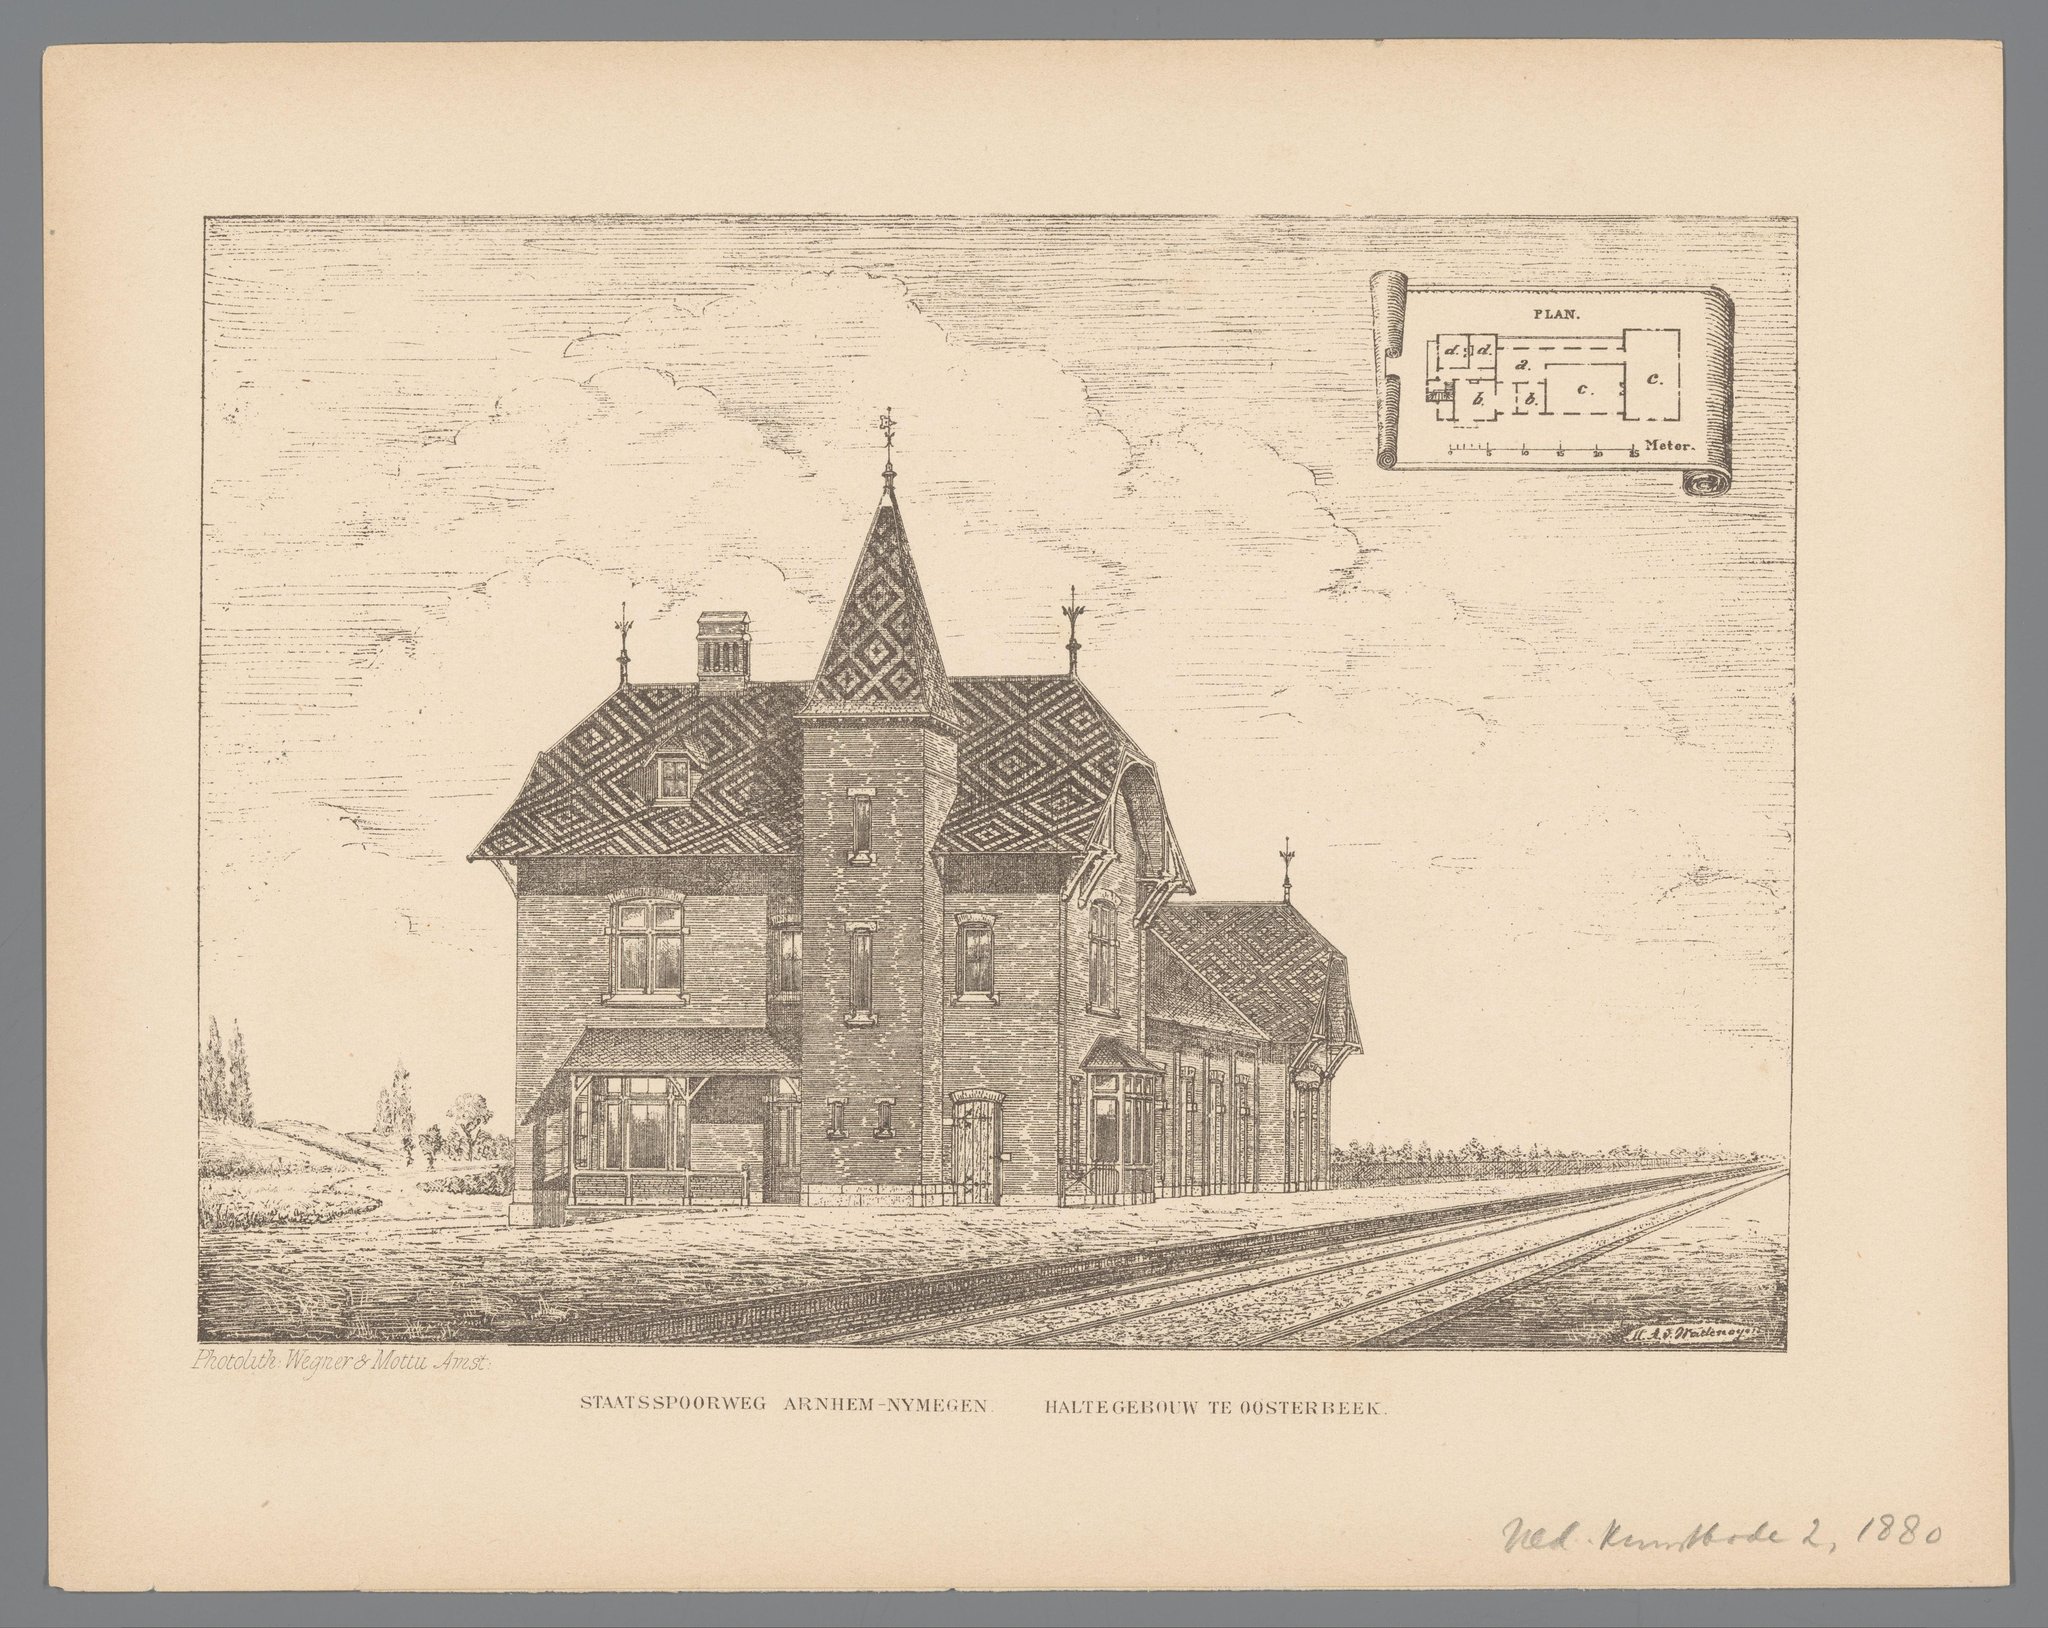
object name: photomechanical print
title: Reproductie van een prent met een gezicht op het station te Oosterbeek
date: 1880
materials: paper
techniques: photolithography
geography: haarlem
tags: railway, train, station; shelter (railway, tramway)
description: Prent uit: Nederlandsche kunstbode, beeldende kunst, oudheidkunde, kunstnijverheid, vol. 2, 1880.